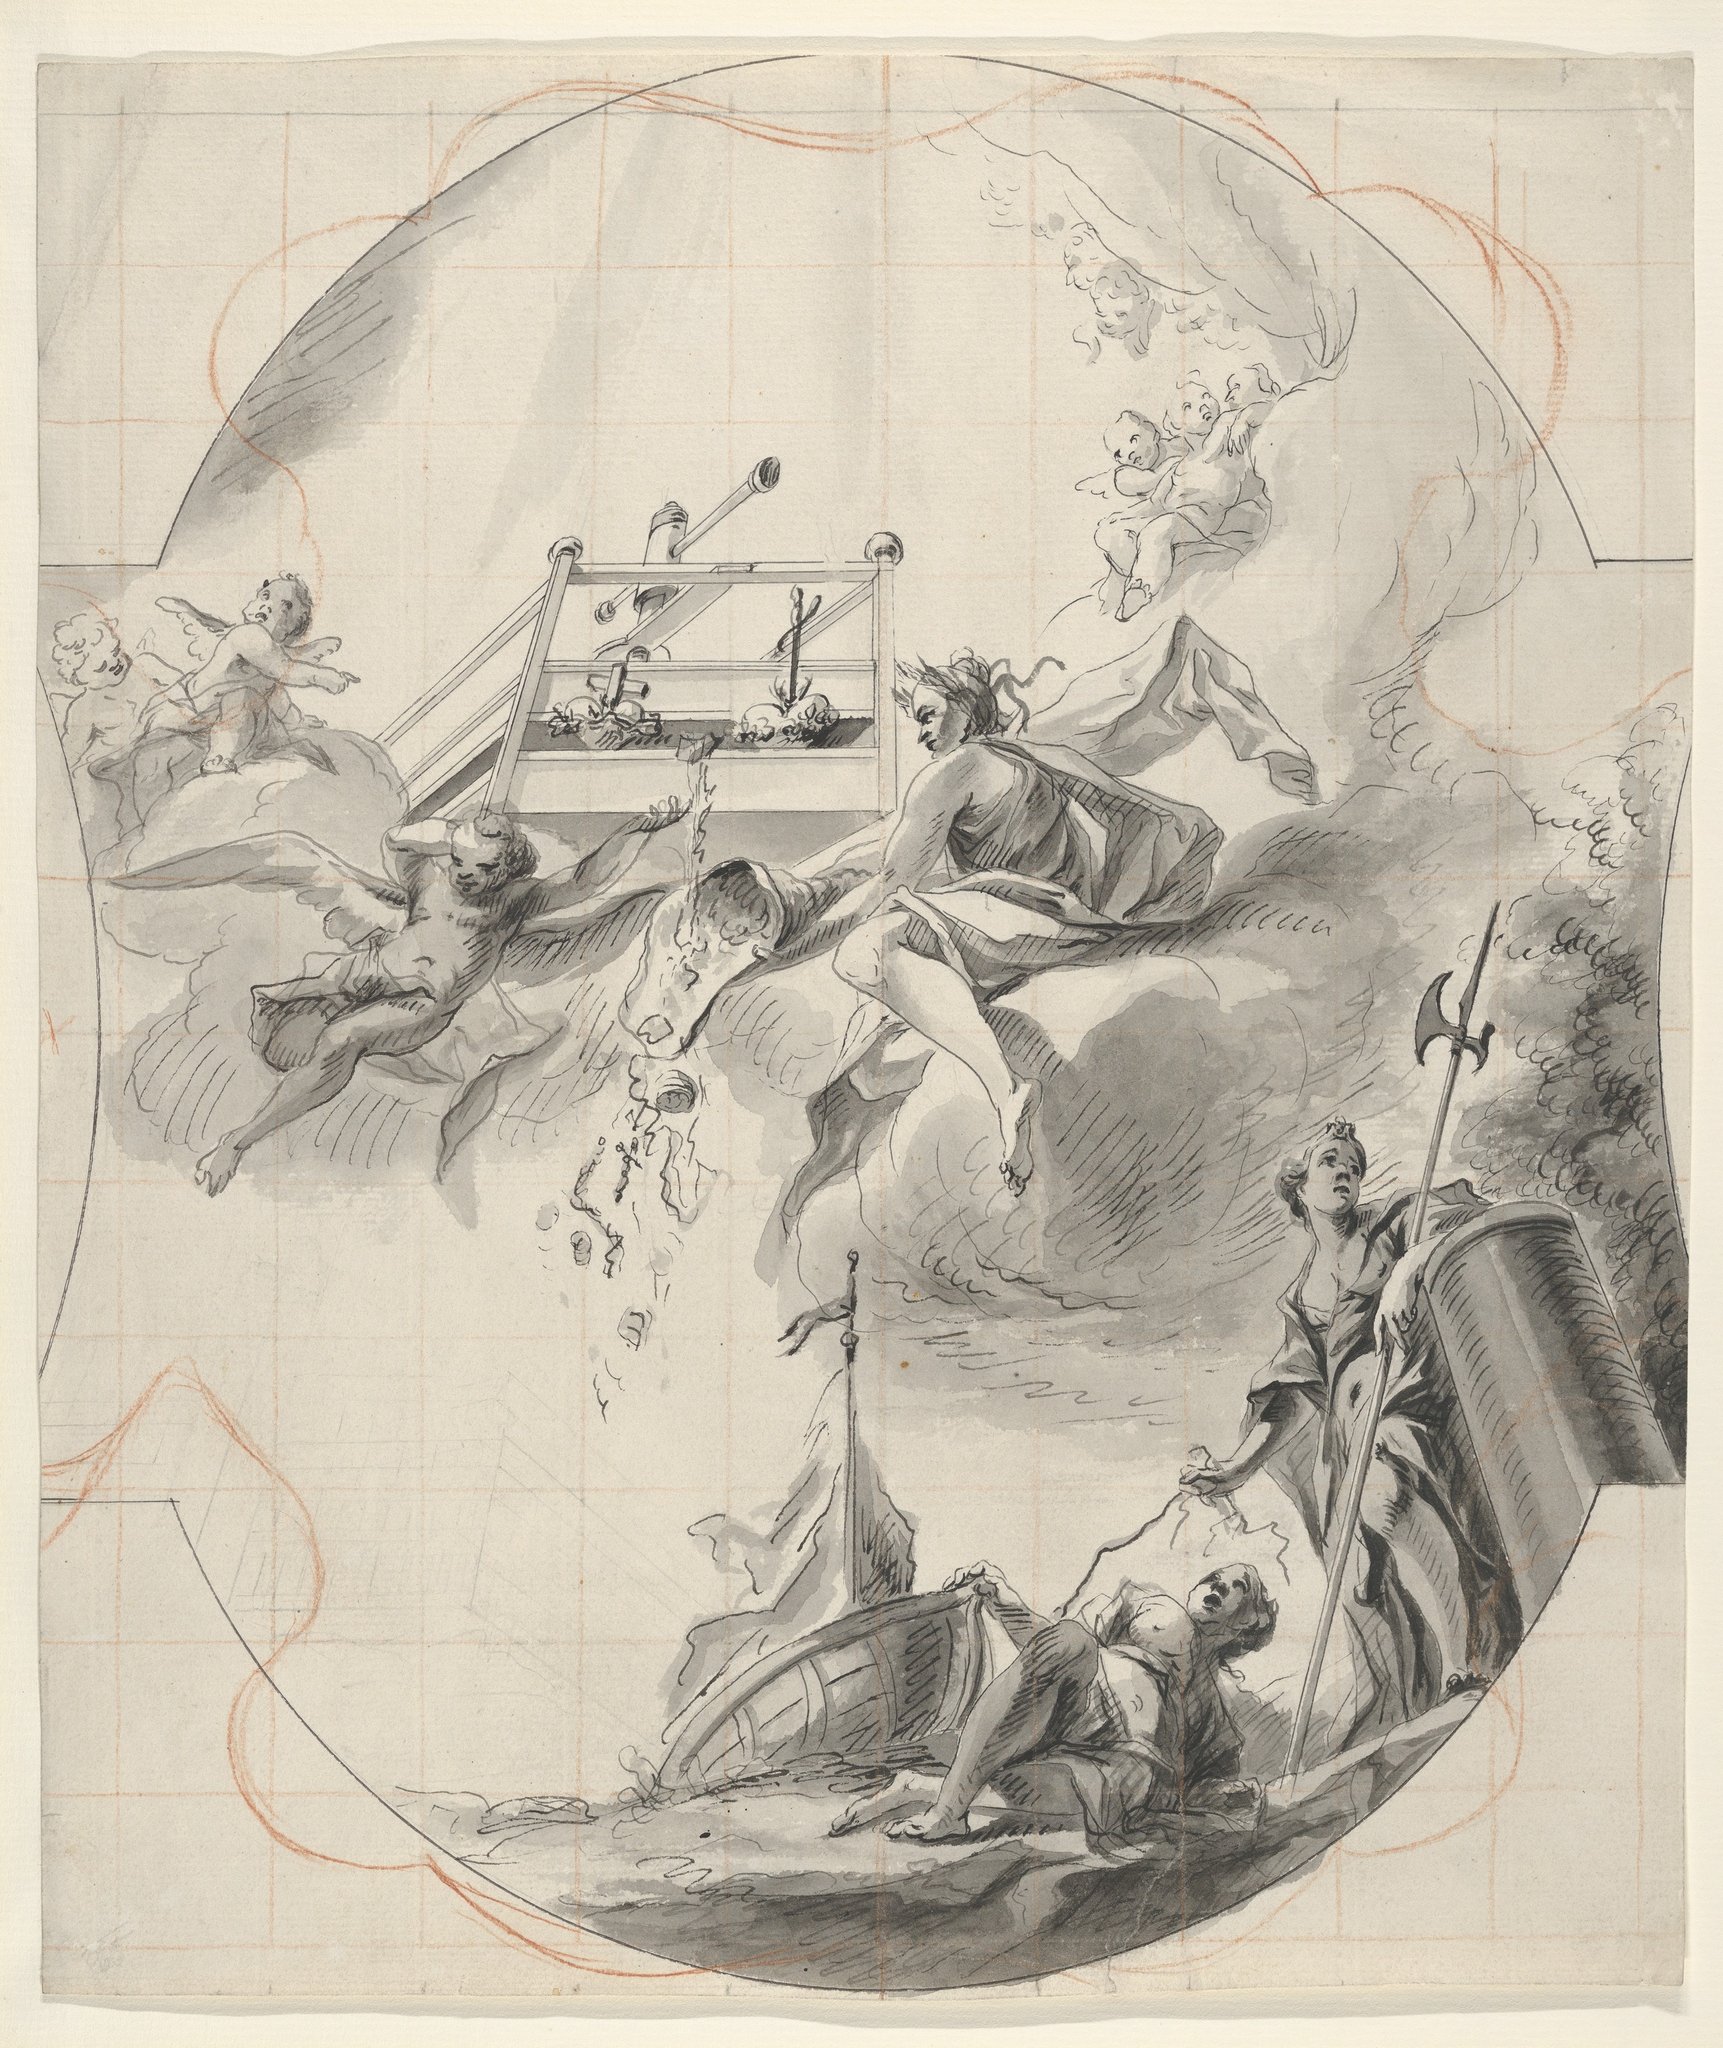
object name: drawing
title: Ceiling Design with the Mystical Wine Press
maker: johann georg dieffenbrunner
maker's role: artist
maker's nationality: german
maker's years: 1718-1786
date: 1750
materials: chalk, ink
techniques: pen, drawing, wash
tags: men,women,boats